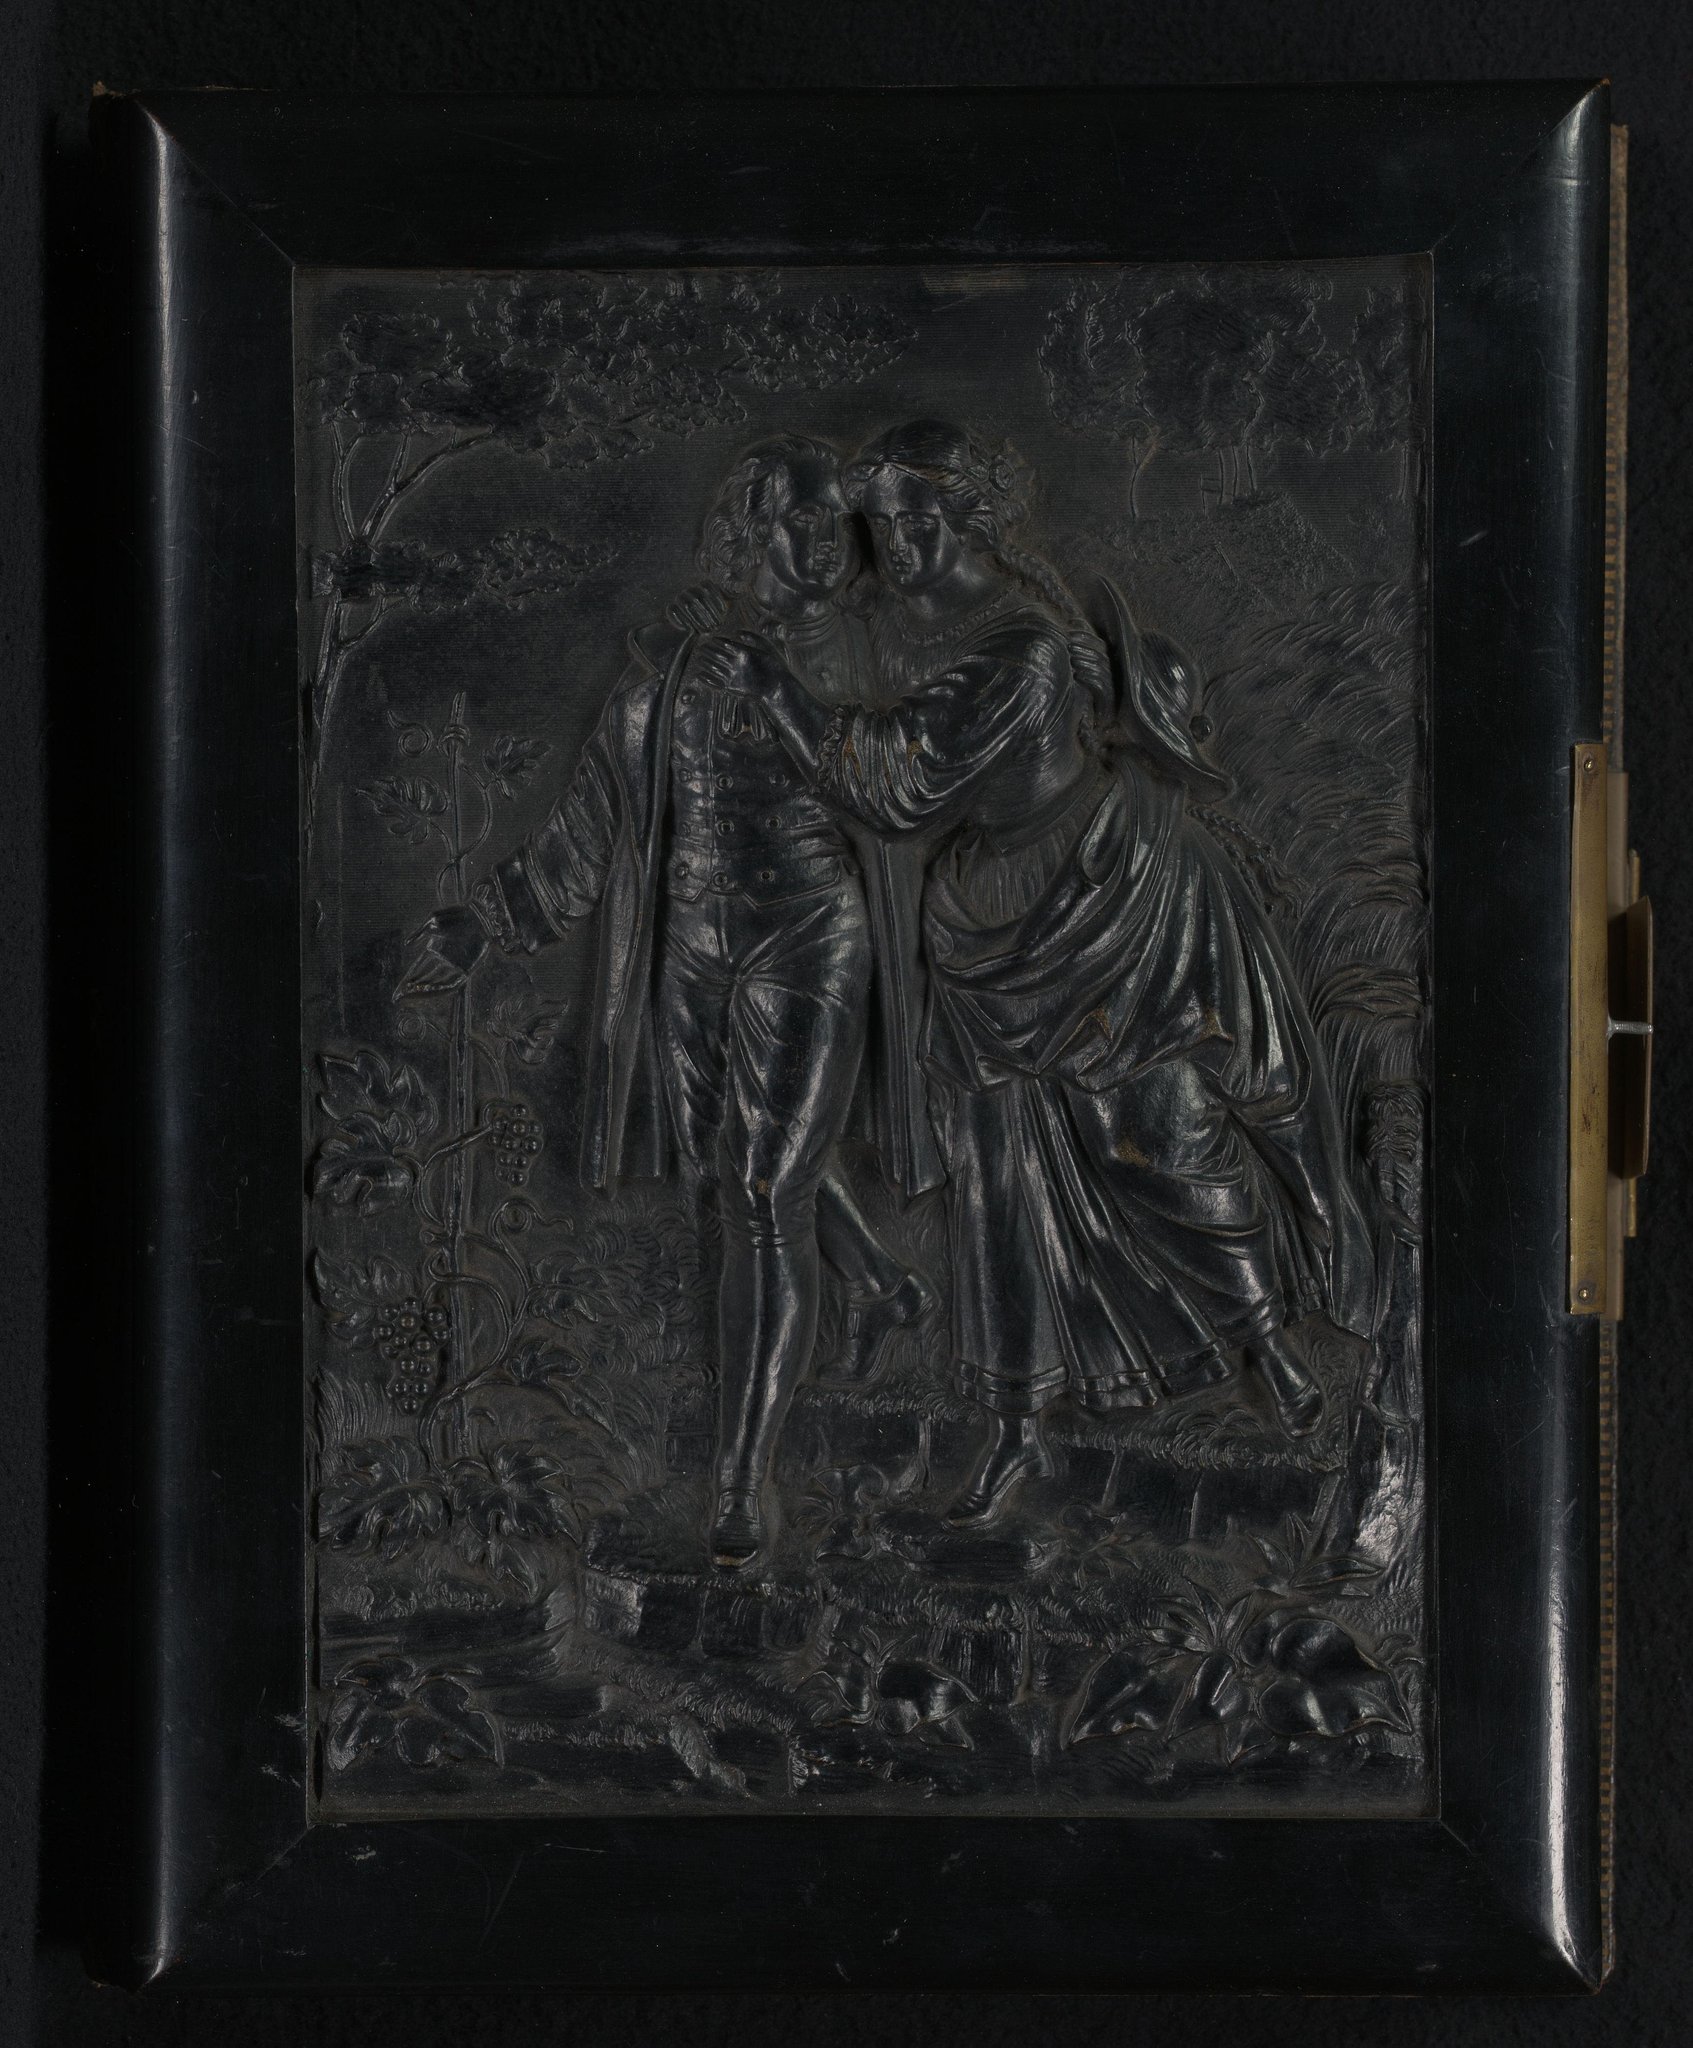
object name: slip in album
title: Familiealbum met 114 foto's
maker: Anonymous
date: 1860-1900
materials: cardboard, leather, metal, photographic support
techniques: decorated paper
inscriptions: collector's mark: ‘Dienst verspreide rijkskillekties/ Kazernestraat 3/'s-Gravenhage (...)’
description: Fotoalbum met familiefoto's van overwegend Belgische fotografen.